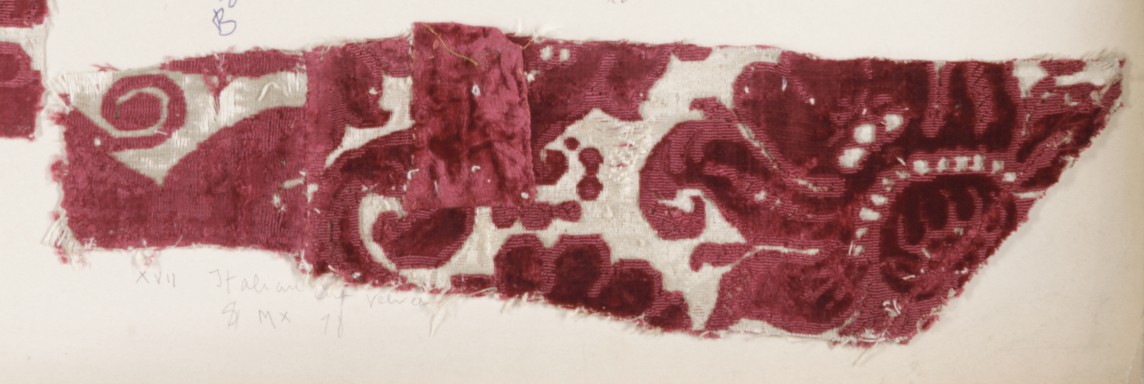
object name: fragment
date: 1601-1700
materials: silk